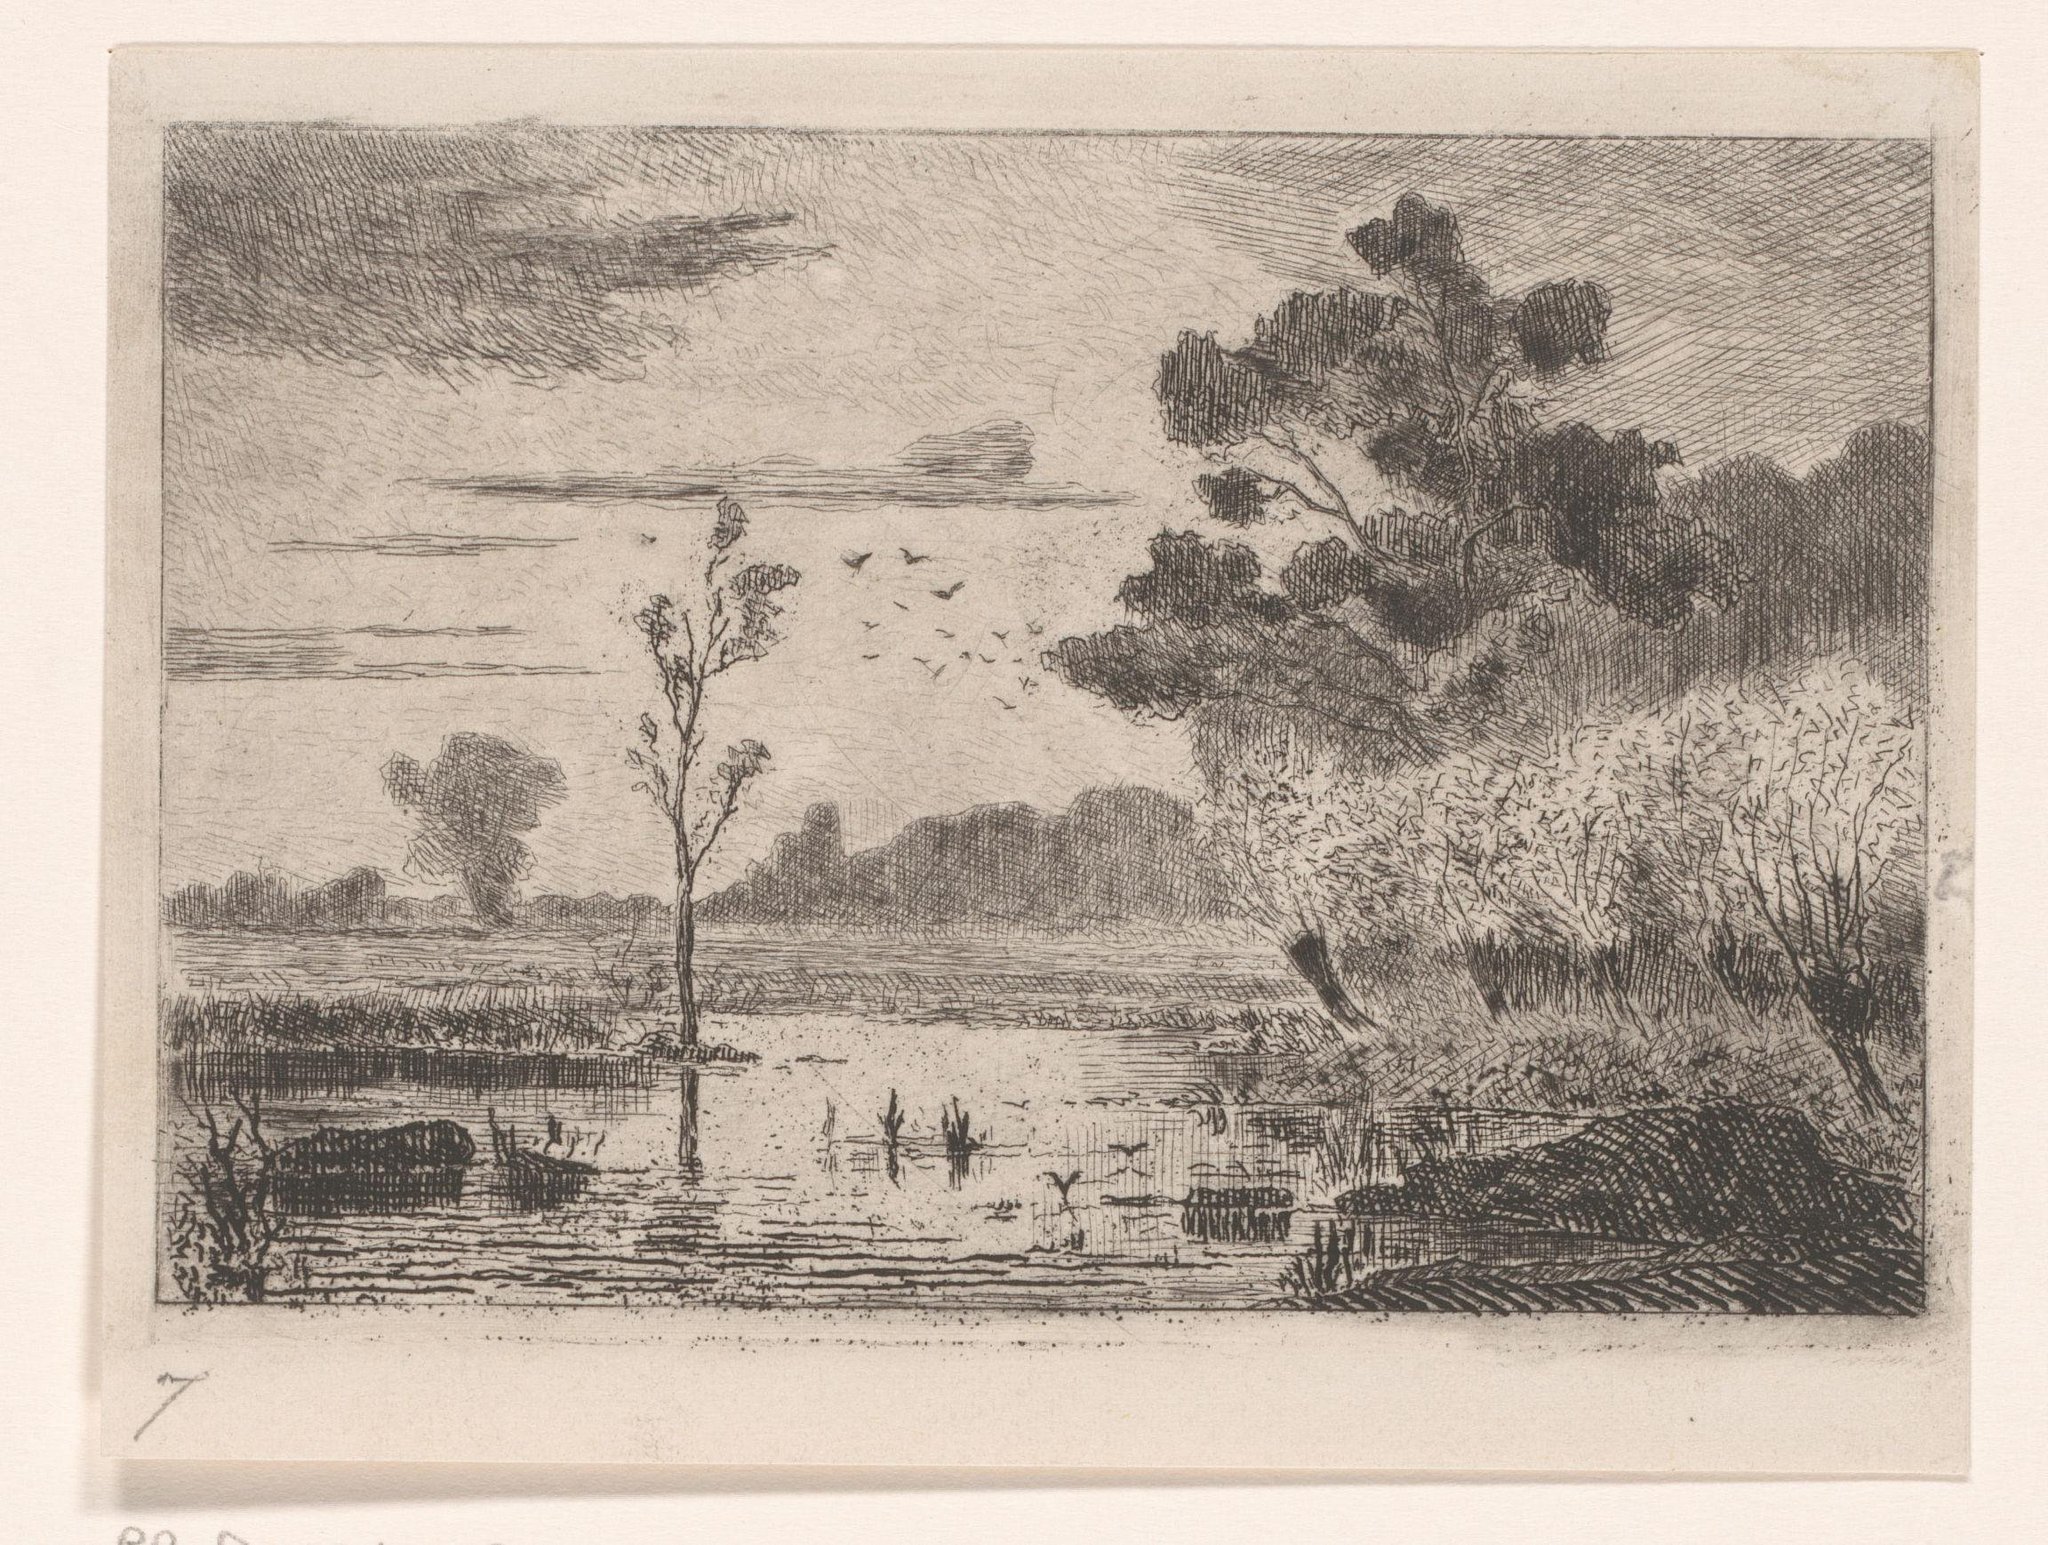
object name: print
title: Landschap met water en knotwilgen bij Noord Deurningen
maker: carel nicolaas storm van s-gravesande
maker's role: draughtsman, print maker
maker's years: 1841-1924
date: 1851-1910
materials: paper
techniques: etching, intaglio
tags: water course, trees: willow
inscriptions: collector's mark: Lugt 2228